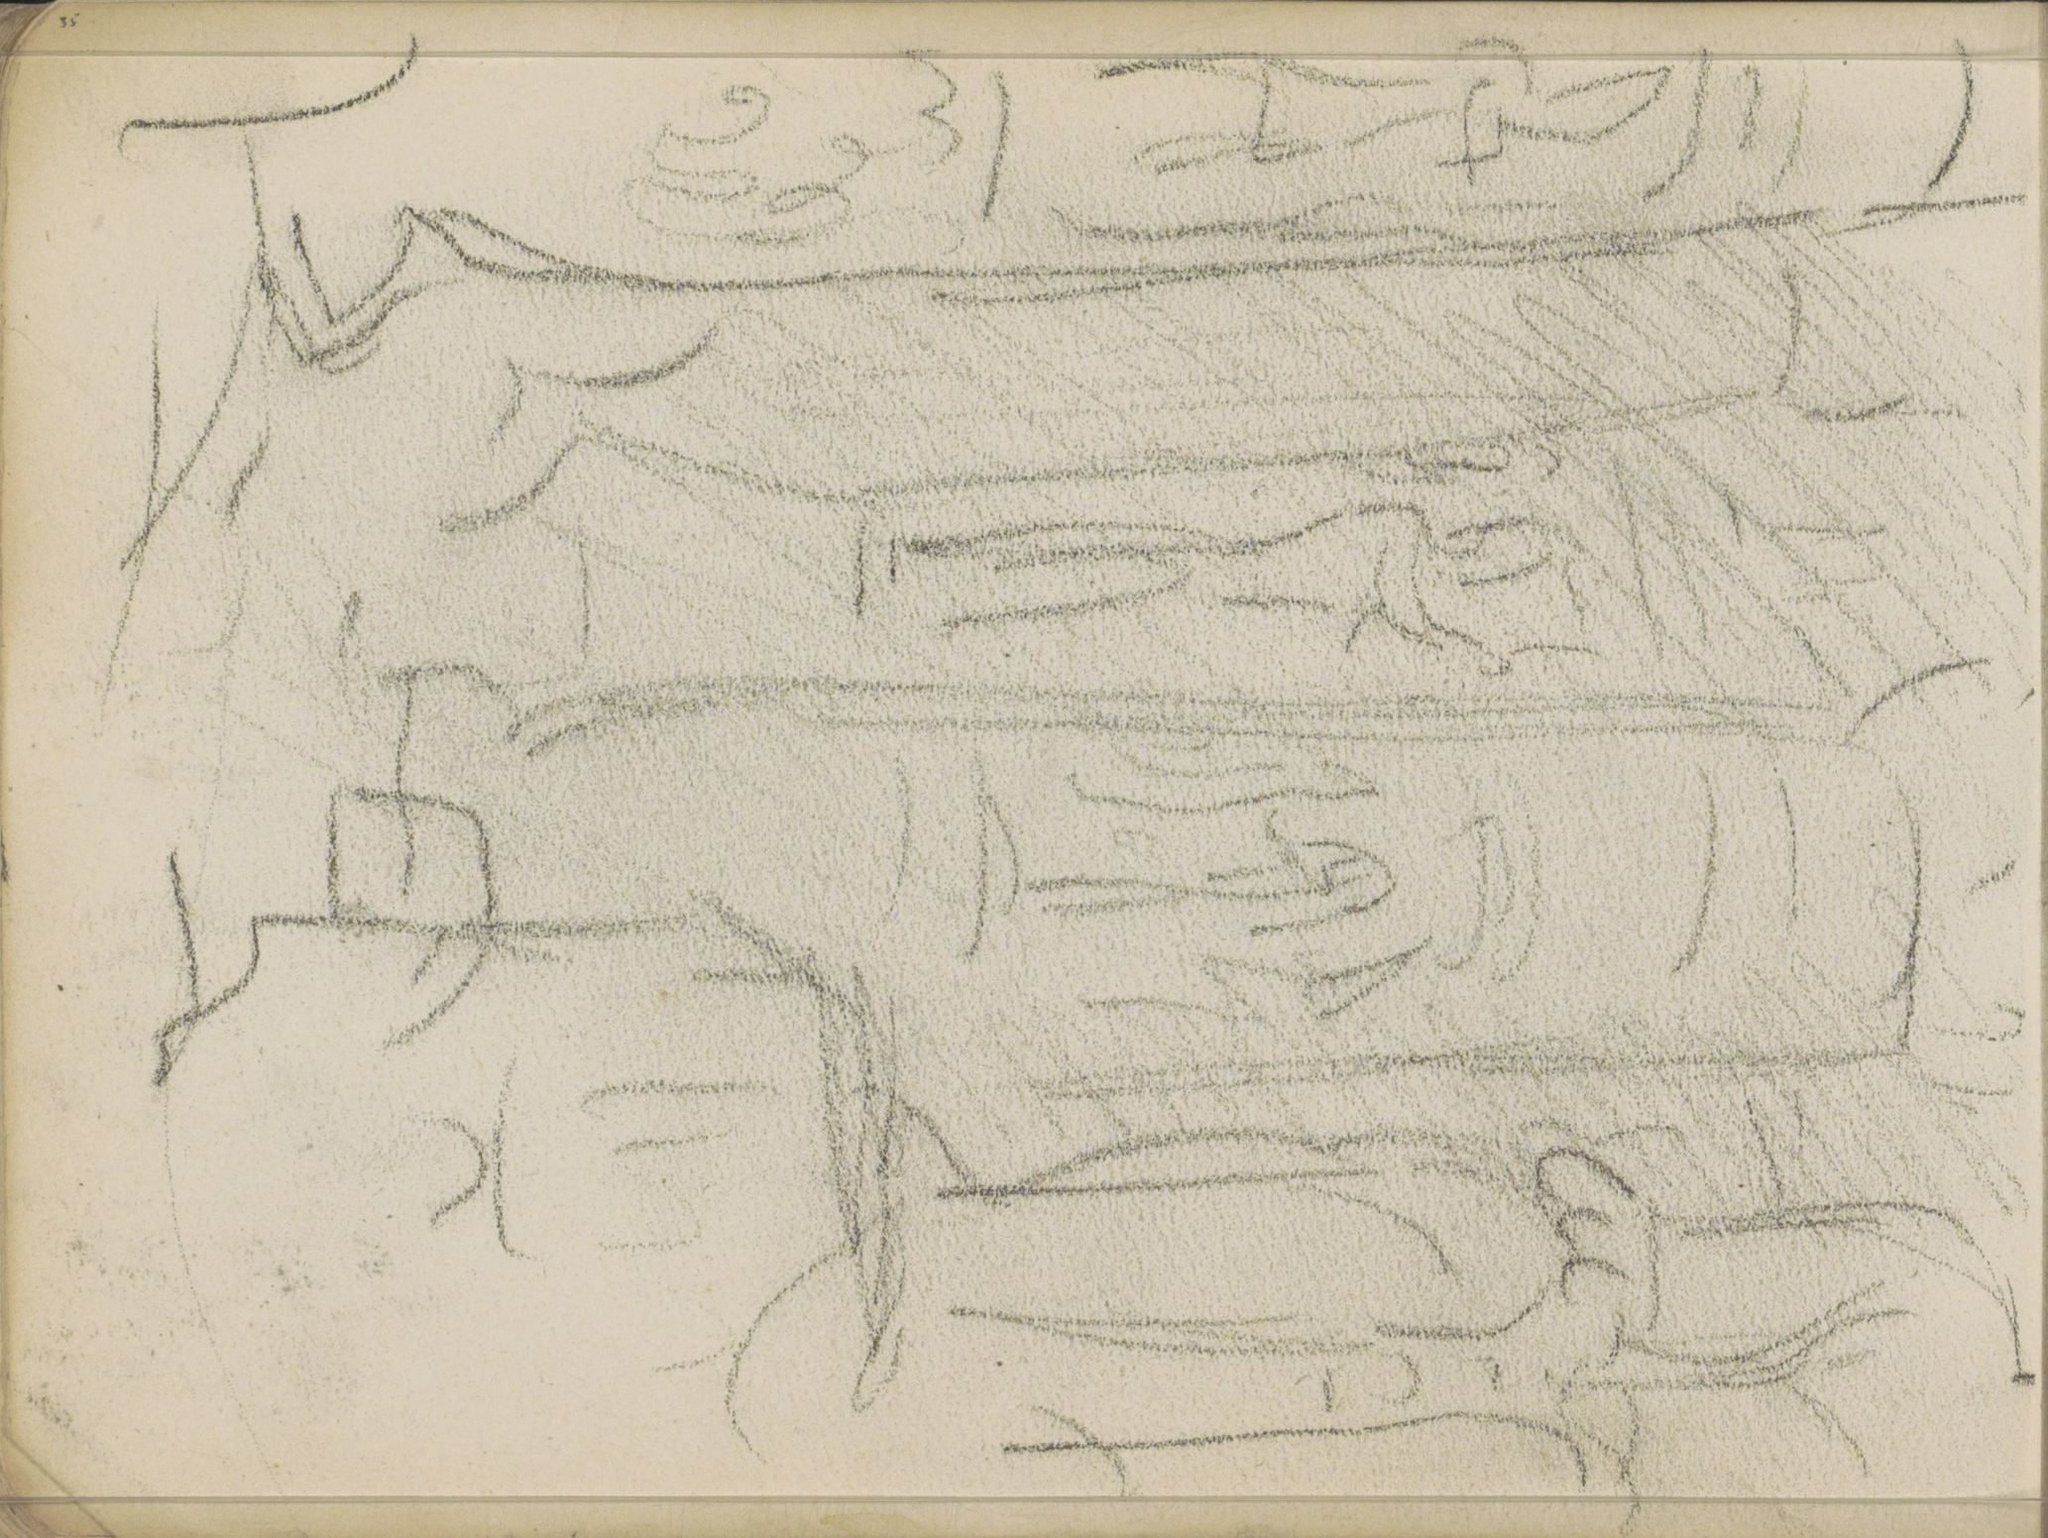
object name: sketchbook leaf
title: Zuilen van de Tempel van Karnak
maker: marius bauer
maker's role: draughtsman, print maker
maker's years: 1867-1932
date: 1919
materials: chalk, paper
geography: luxor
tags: temple, shrine ~ egyptian religion, sculpture (+ relief ~ sculpture)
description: Op de zuilen staan voorstellingen in reliëf. Pagina 35 uit een schetsboek met 28 bladen.